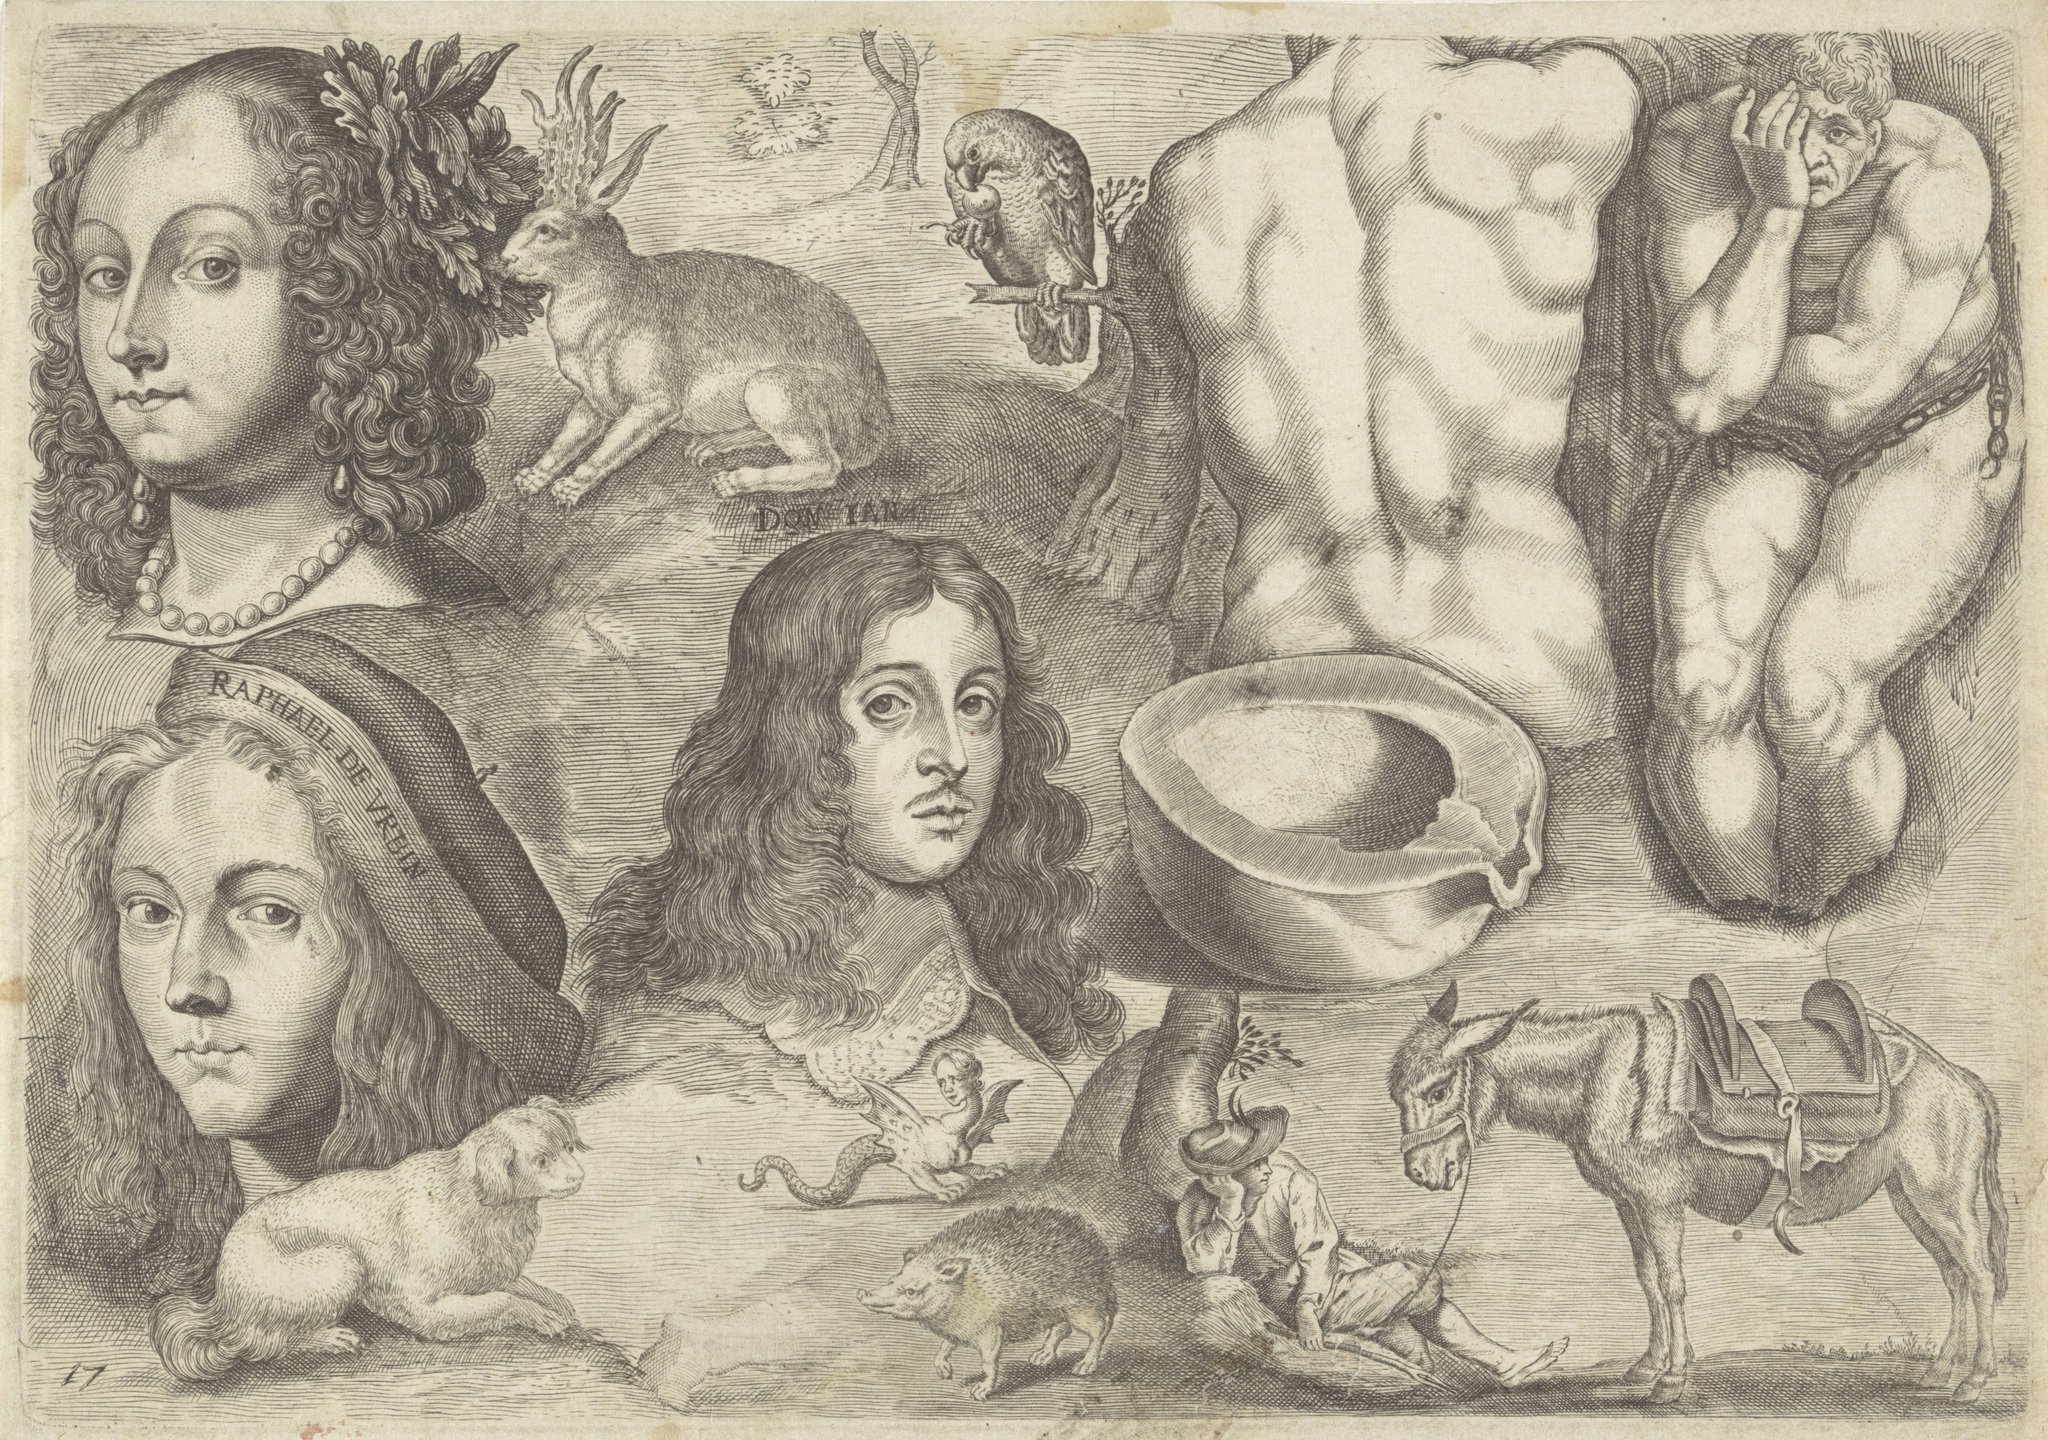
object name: print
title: Tekenvoorbeelden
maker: michael snijders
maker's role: print maker, publisher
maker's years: 1586-1672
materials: paper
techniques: engraving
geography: antwerp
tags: rome, painter, rafaël, mechelen, sculptor, lucas faydherbe, head (human), model-books ~ implements of painter, rodents: hare - ff - fabulous animals (sometimes wrongly called 'grotesques'); 'mostri' (ripa), ass, donkey, siren (fabulous bird with woman's head), ornamental birds: parrot, (traveller) resting in the open air, torso, other mammals: hedgehog, dog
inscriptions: number: ‘17’, collector's mark: Lugt 2228, collector's mark: Lugt 2760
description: Zeventiende prent uit een serie tekenvoorbeelden van onbekende omvang. Studieblad met koppen, dieren, figuren. Linksonder portret van Raphaël en daarnaast portret van Lucas Faydherbe. Linksboven portret van Maria Ruthven en haas met horens. Rechtsboven figuur uit het Laatste Oordeel van Michelangelo, met daarnaast een papegaai. Rechtsonder diverse figuren waaronder liggende man met ezel.